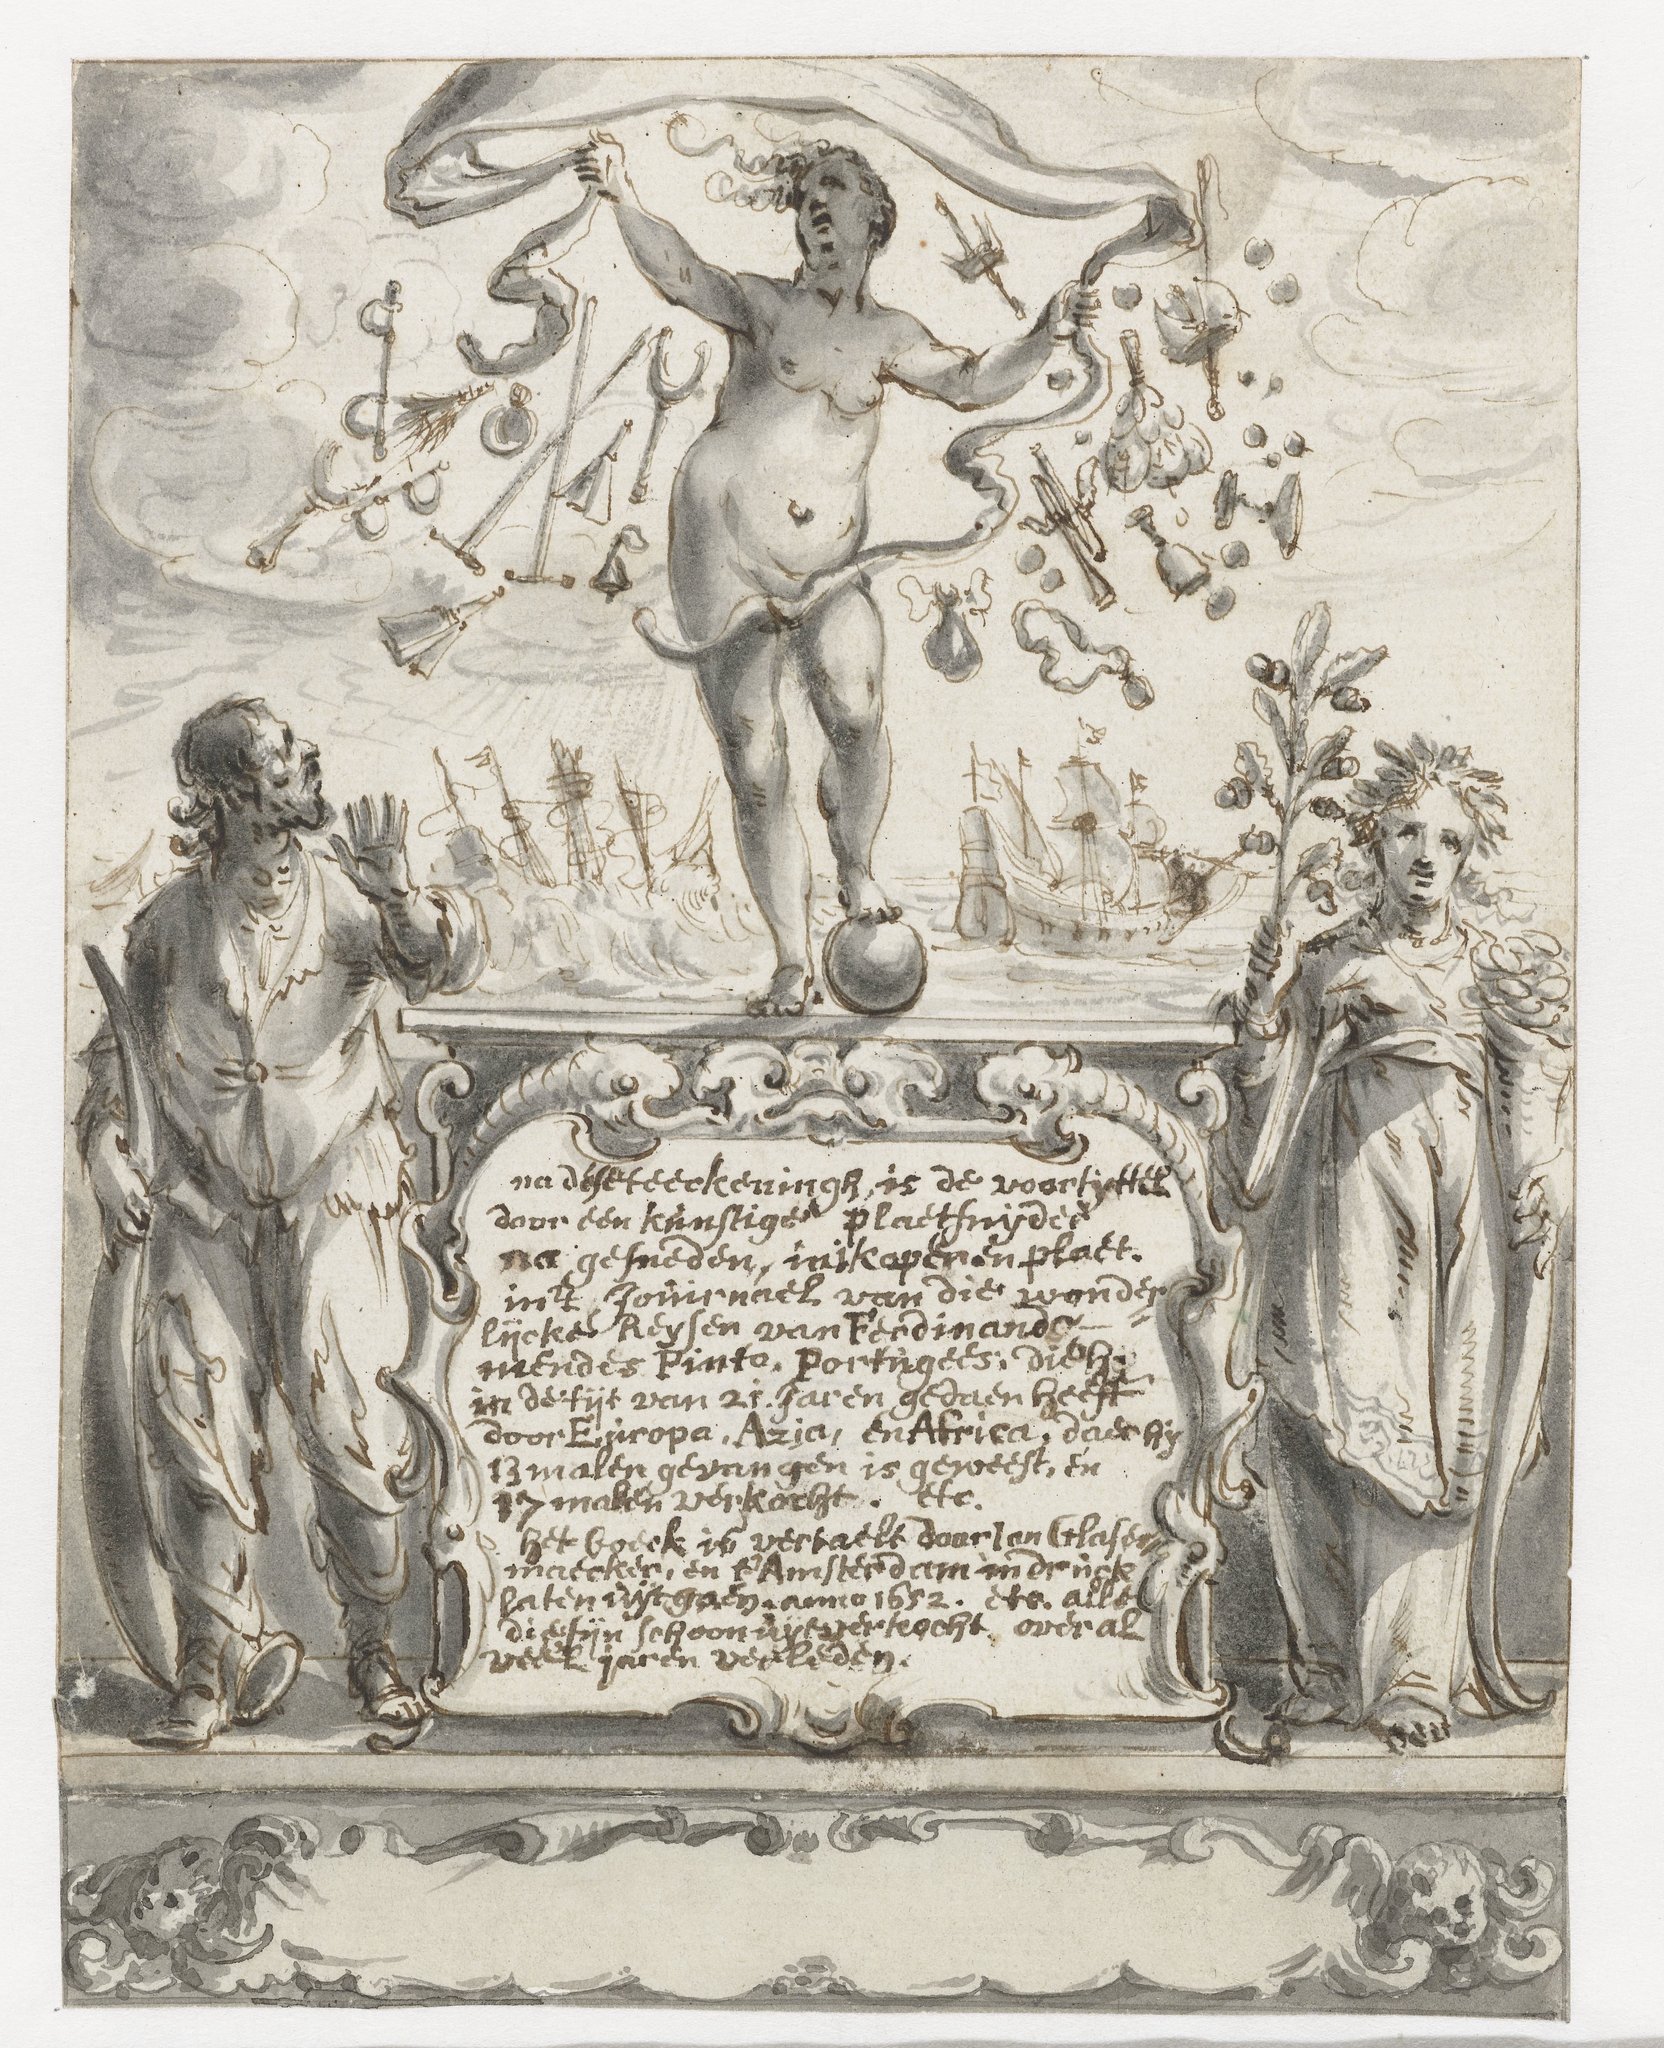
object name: design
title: Frontispiece Design for De wonderlyke reizen van Fernando Mendez Pinto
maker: pieter jansz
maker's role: draughtsman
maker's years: 1602-1672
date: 1652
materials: ink, paper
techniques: brush, pen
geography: amsterdam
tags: shipwreck, adversity, misfortune, bad luck; 'fortuna infelice', 'infortunio' (ripa), luck, fortune, lot; 'fato', 'fortuna', 'fortuna aurea', 'fortuna buona', 'fortuna pacifica overo clemente', 'sorte' (ripa), welfare, prosperity; 'felicità publica', 'prosperità della vita', 'salute' (ripa)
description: Fortune takes centre stage, and is depicted nude, as was customary at the time. She rests one foot on a globe as a sign that fortune is fickle and one can quickly fall from grace. The man at her side and the seascape in the background represent misfortune. All kinds of instruments of torture are being cast over him. The woman at the right with the horn of plenty personifies Prosperity.